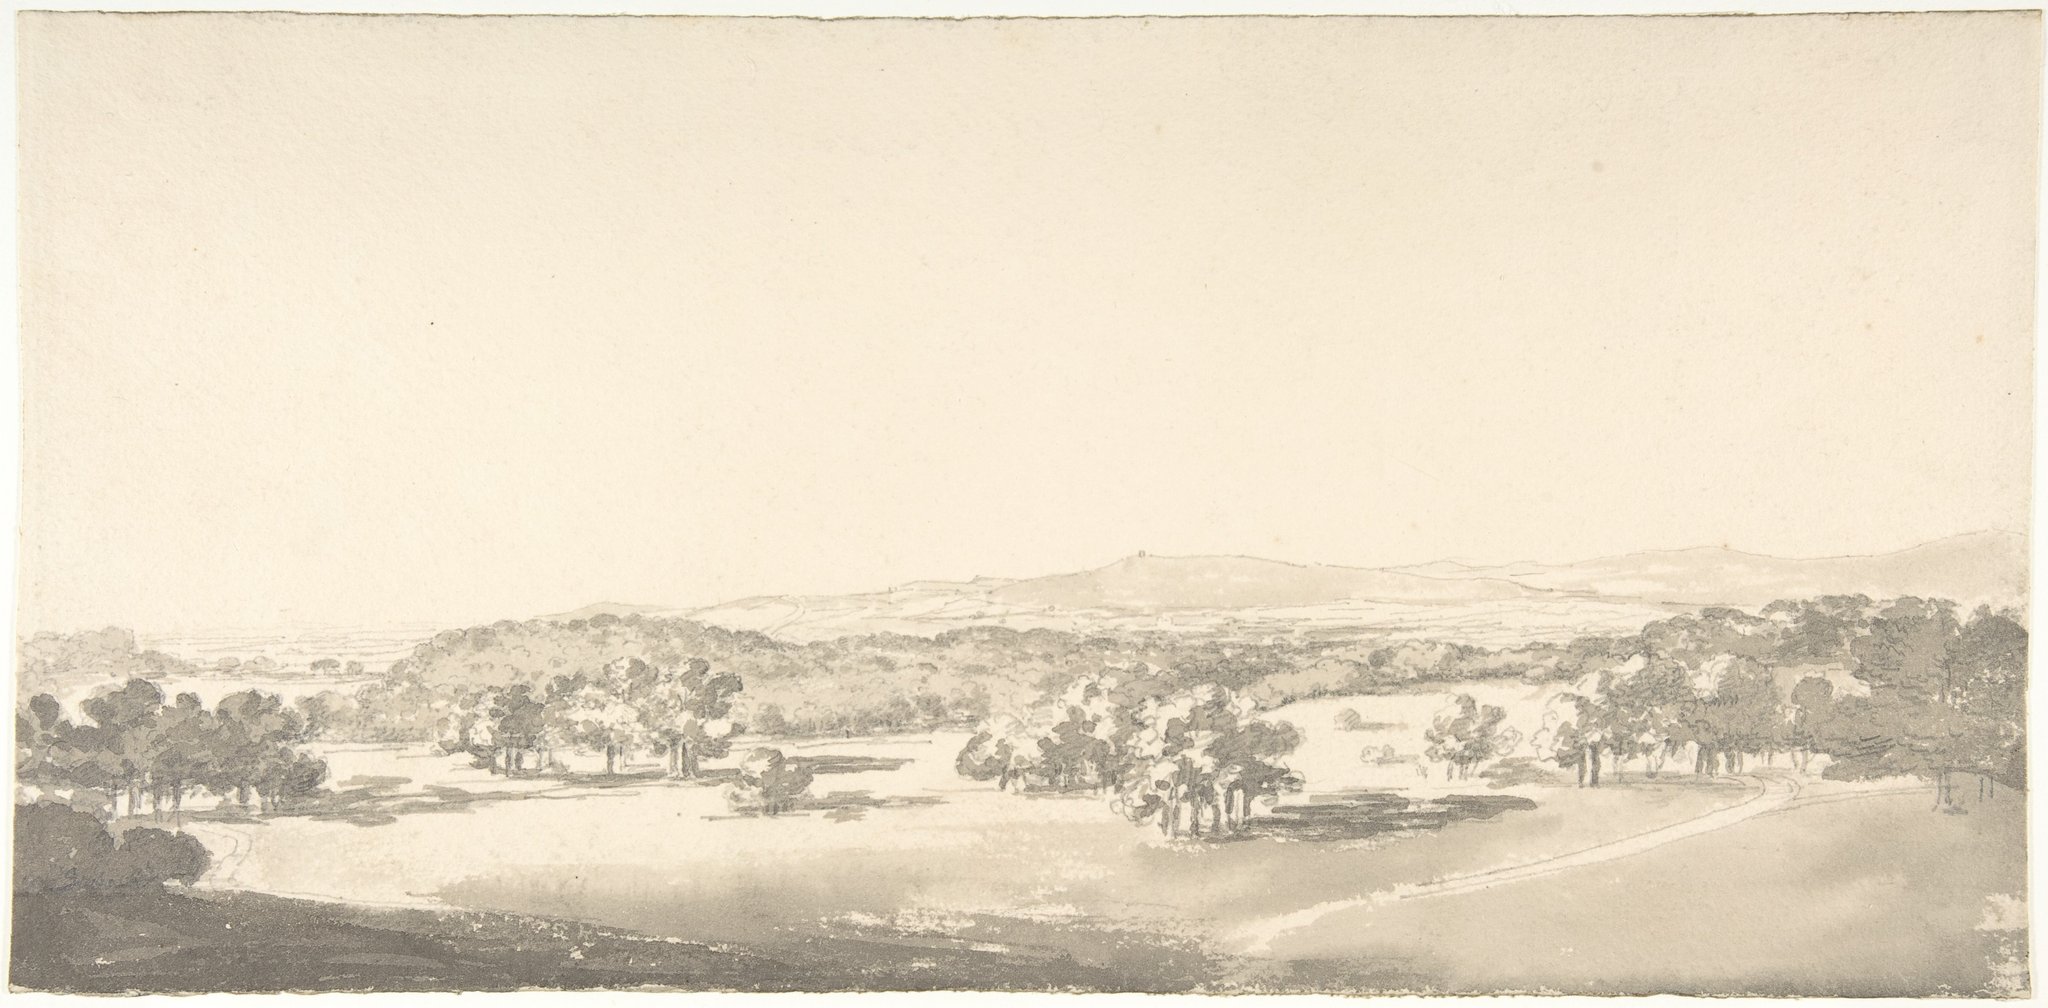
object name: drawing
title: Derbyshire landscape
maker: john constable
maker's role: artist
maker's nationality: british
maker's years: 1776-1837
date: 1801-1802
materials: graphite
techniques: brush, wash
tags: landscapes,trees